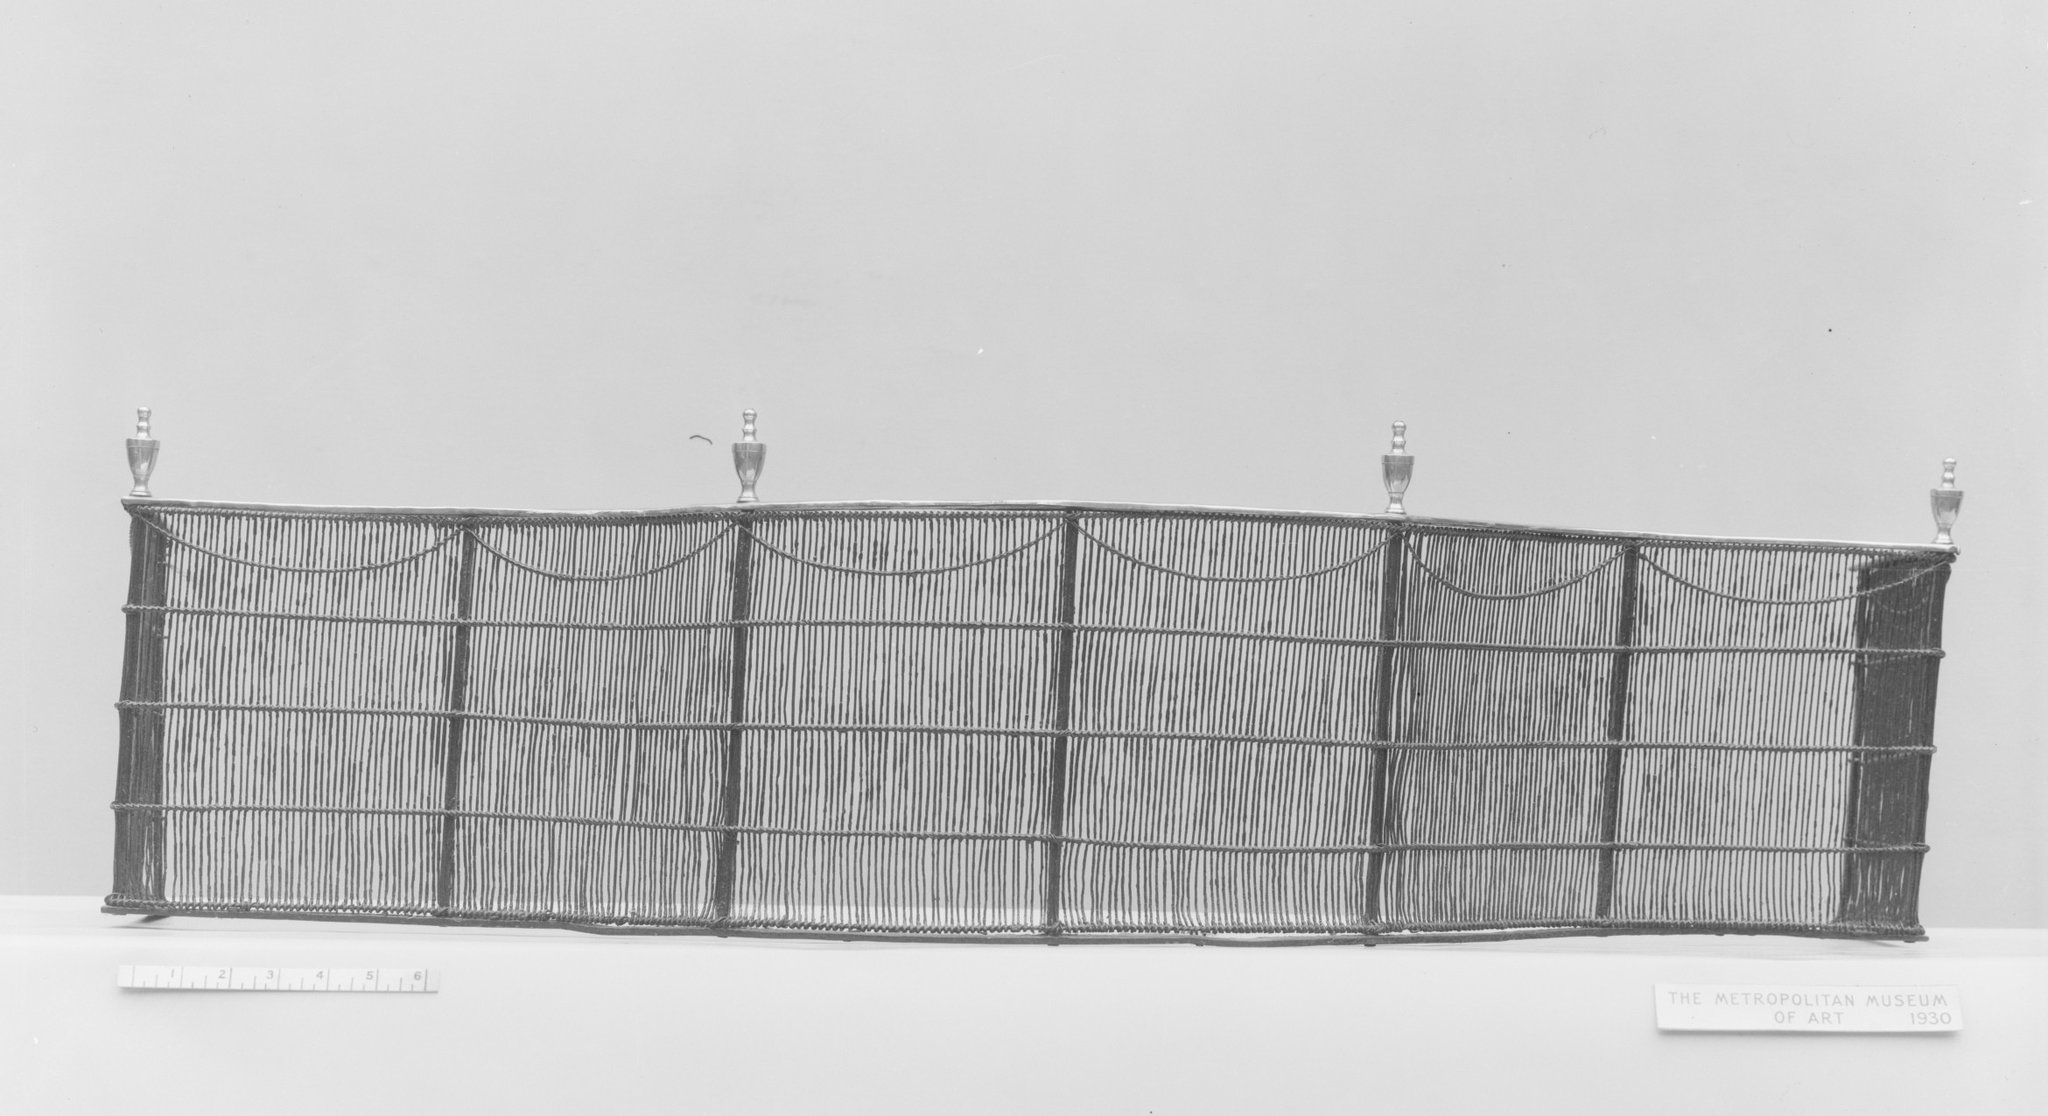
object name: fender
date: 1700-1800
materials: brass, iron